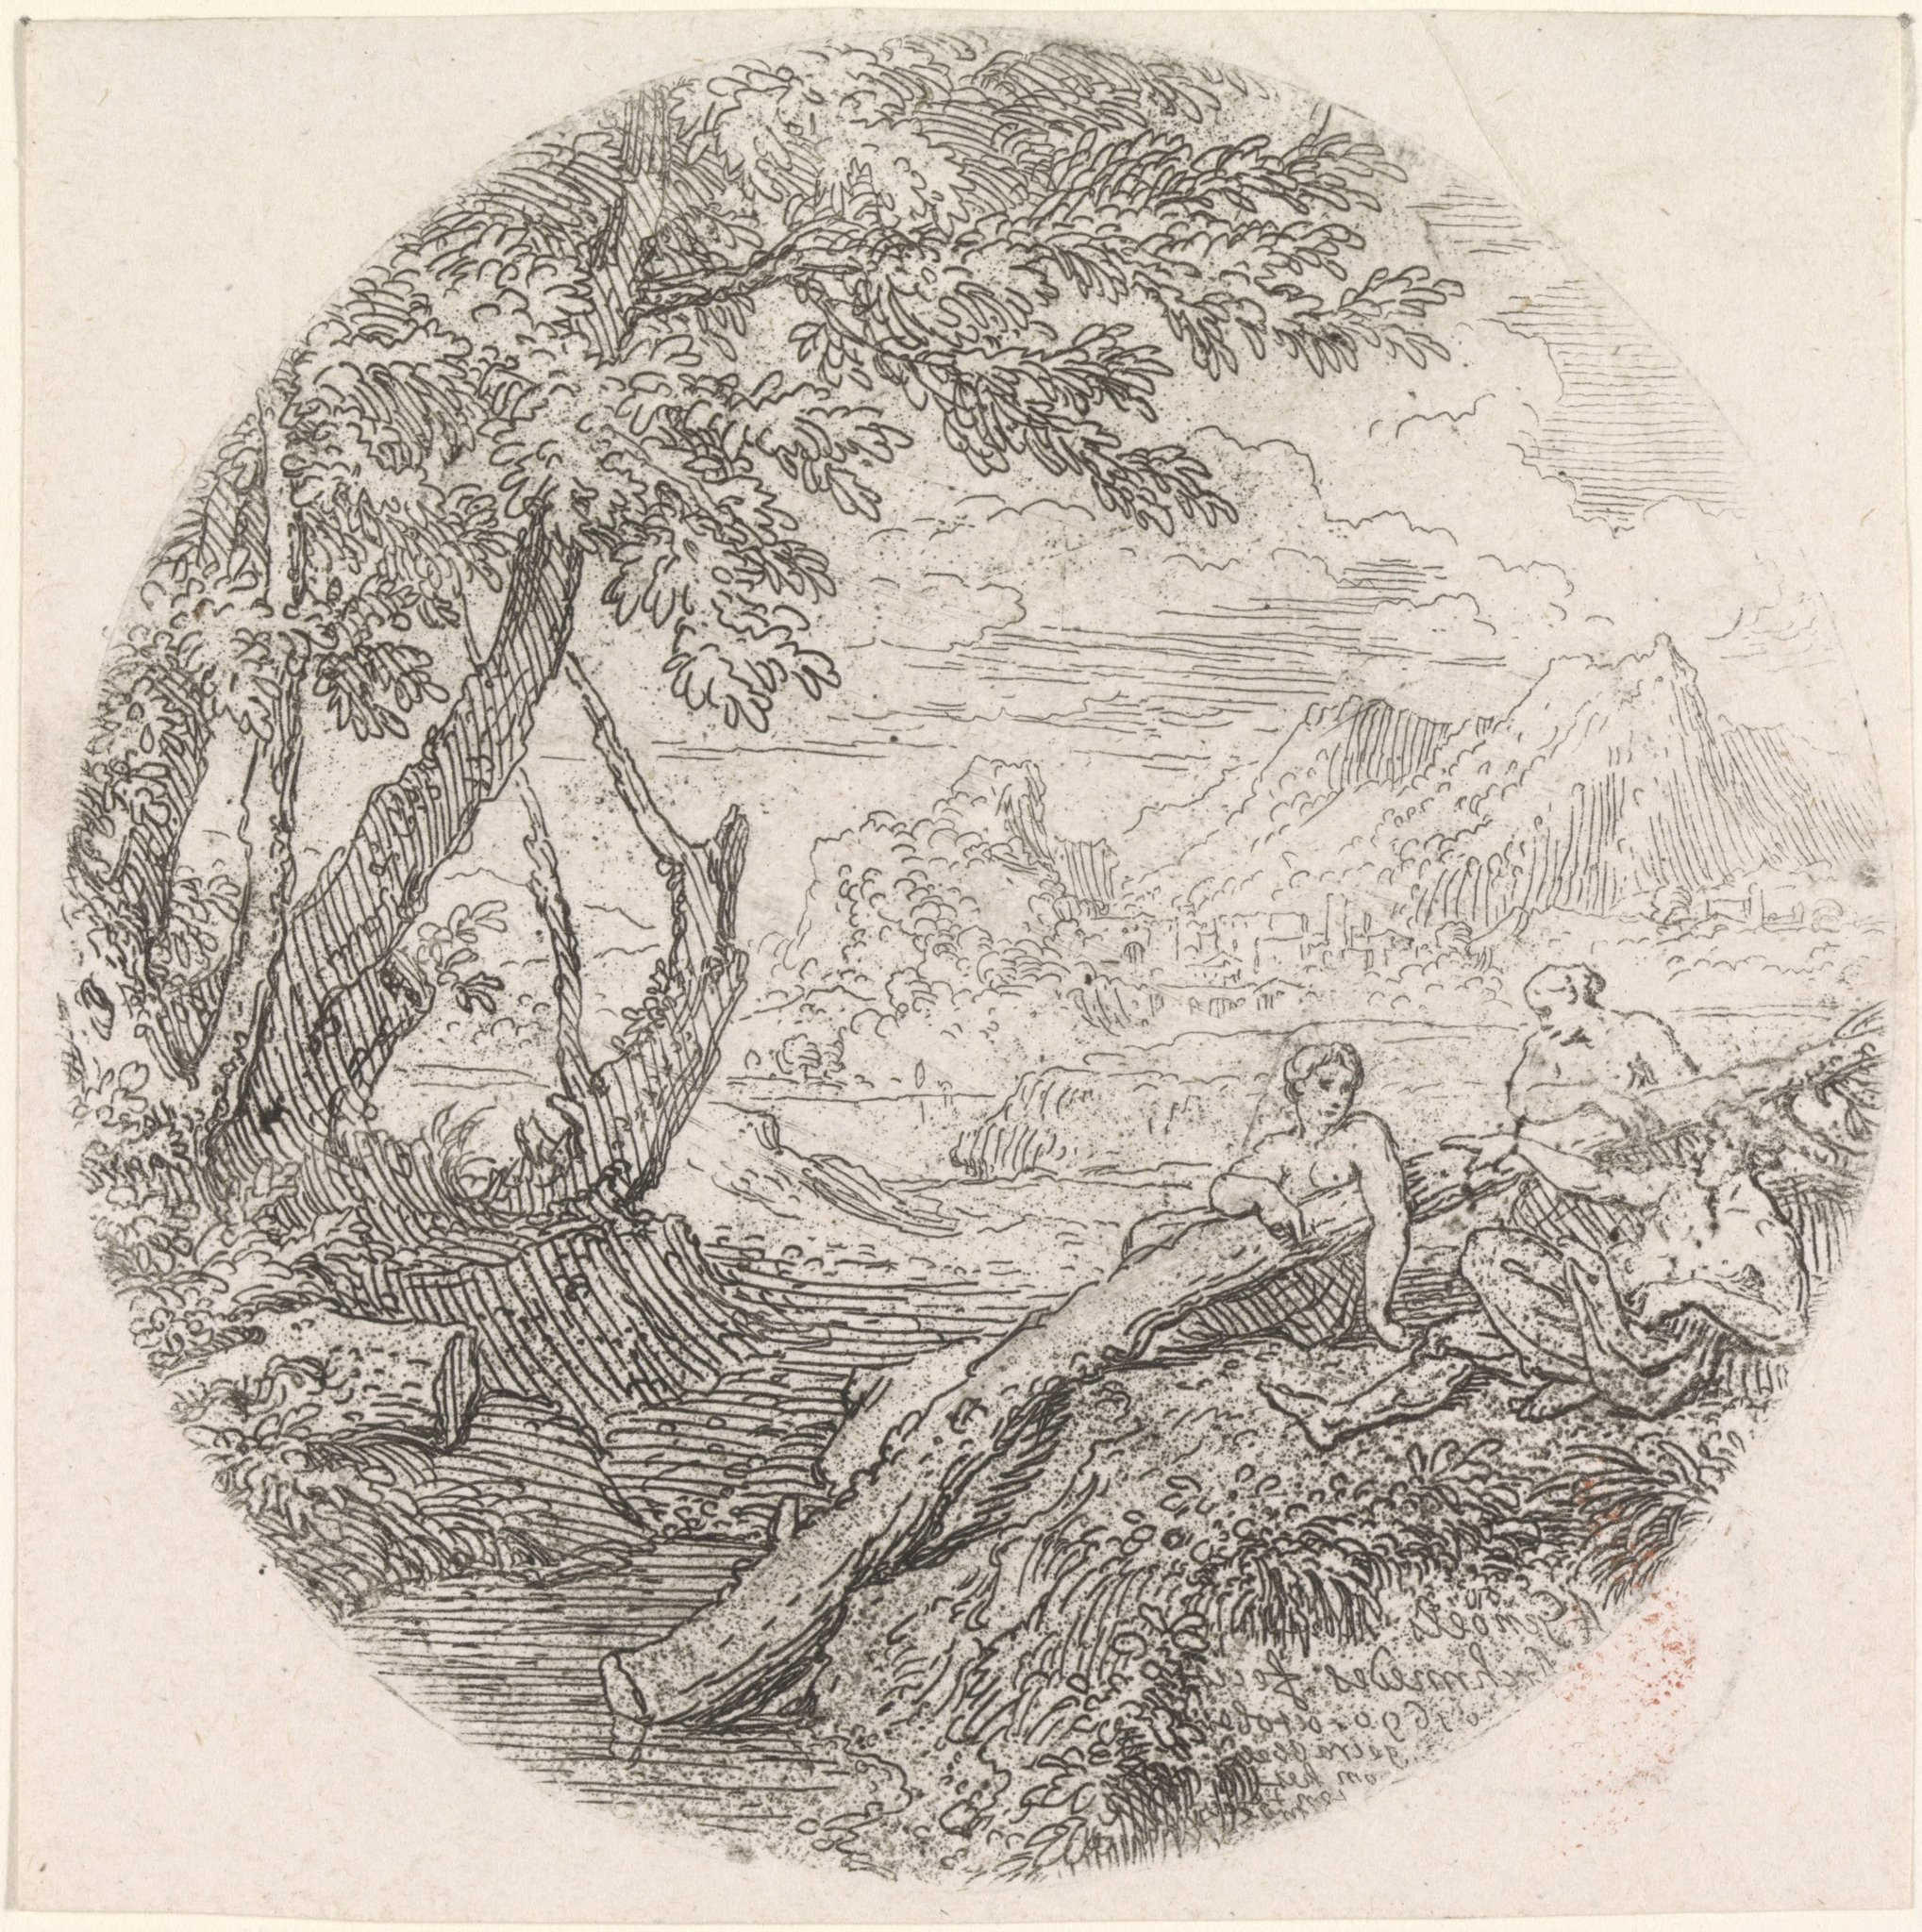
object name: print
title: Landschap met omgevallen boom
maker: abraham genoels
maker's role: draughtsman, print maker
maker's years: 1640-1723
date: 1690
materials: paper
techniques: etching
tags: trees, mountains (+ landscape with figures, staffage)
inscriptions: collector's mark: Lugt 240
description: Drie halfnaakte figuren naast een omgevallen boom in een landschap.